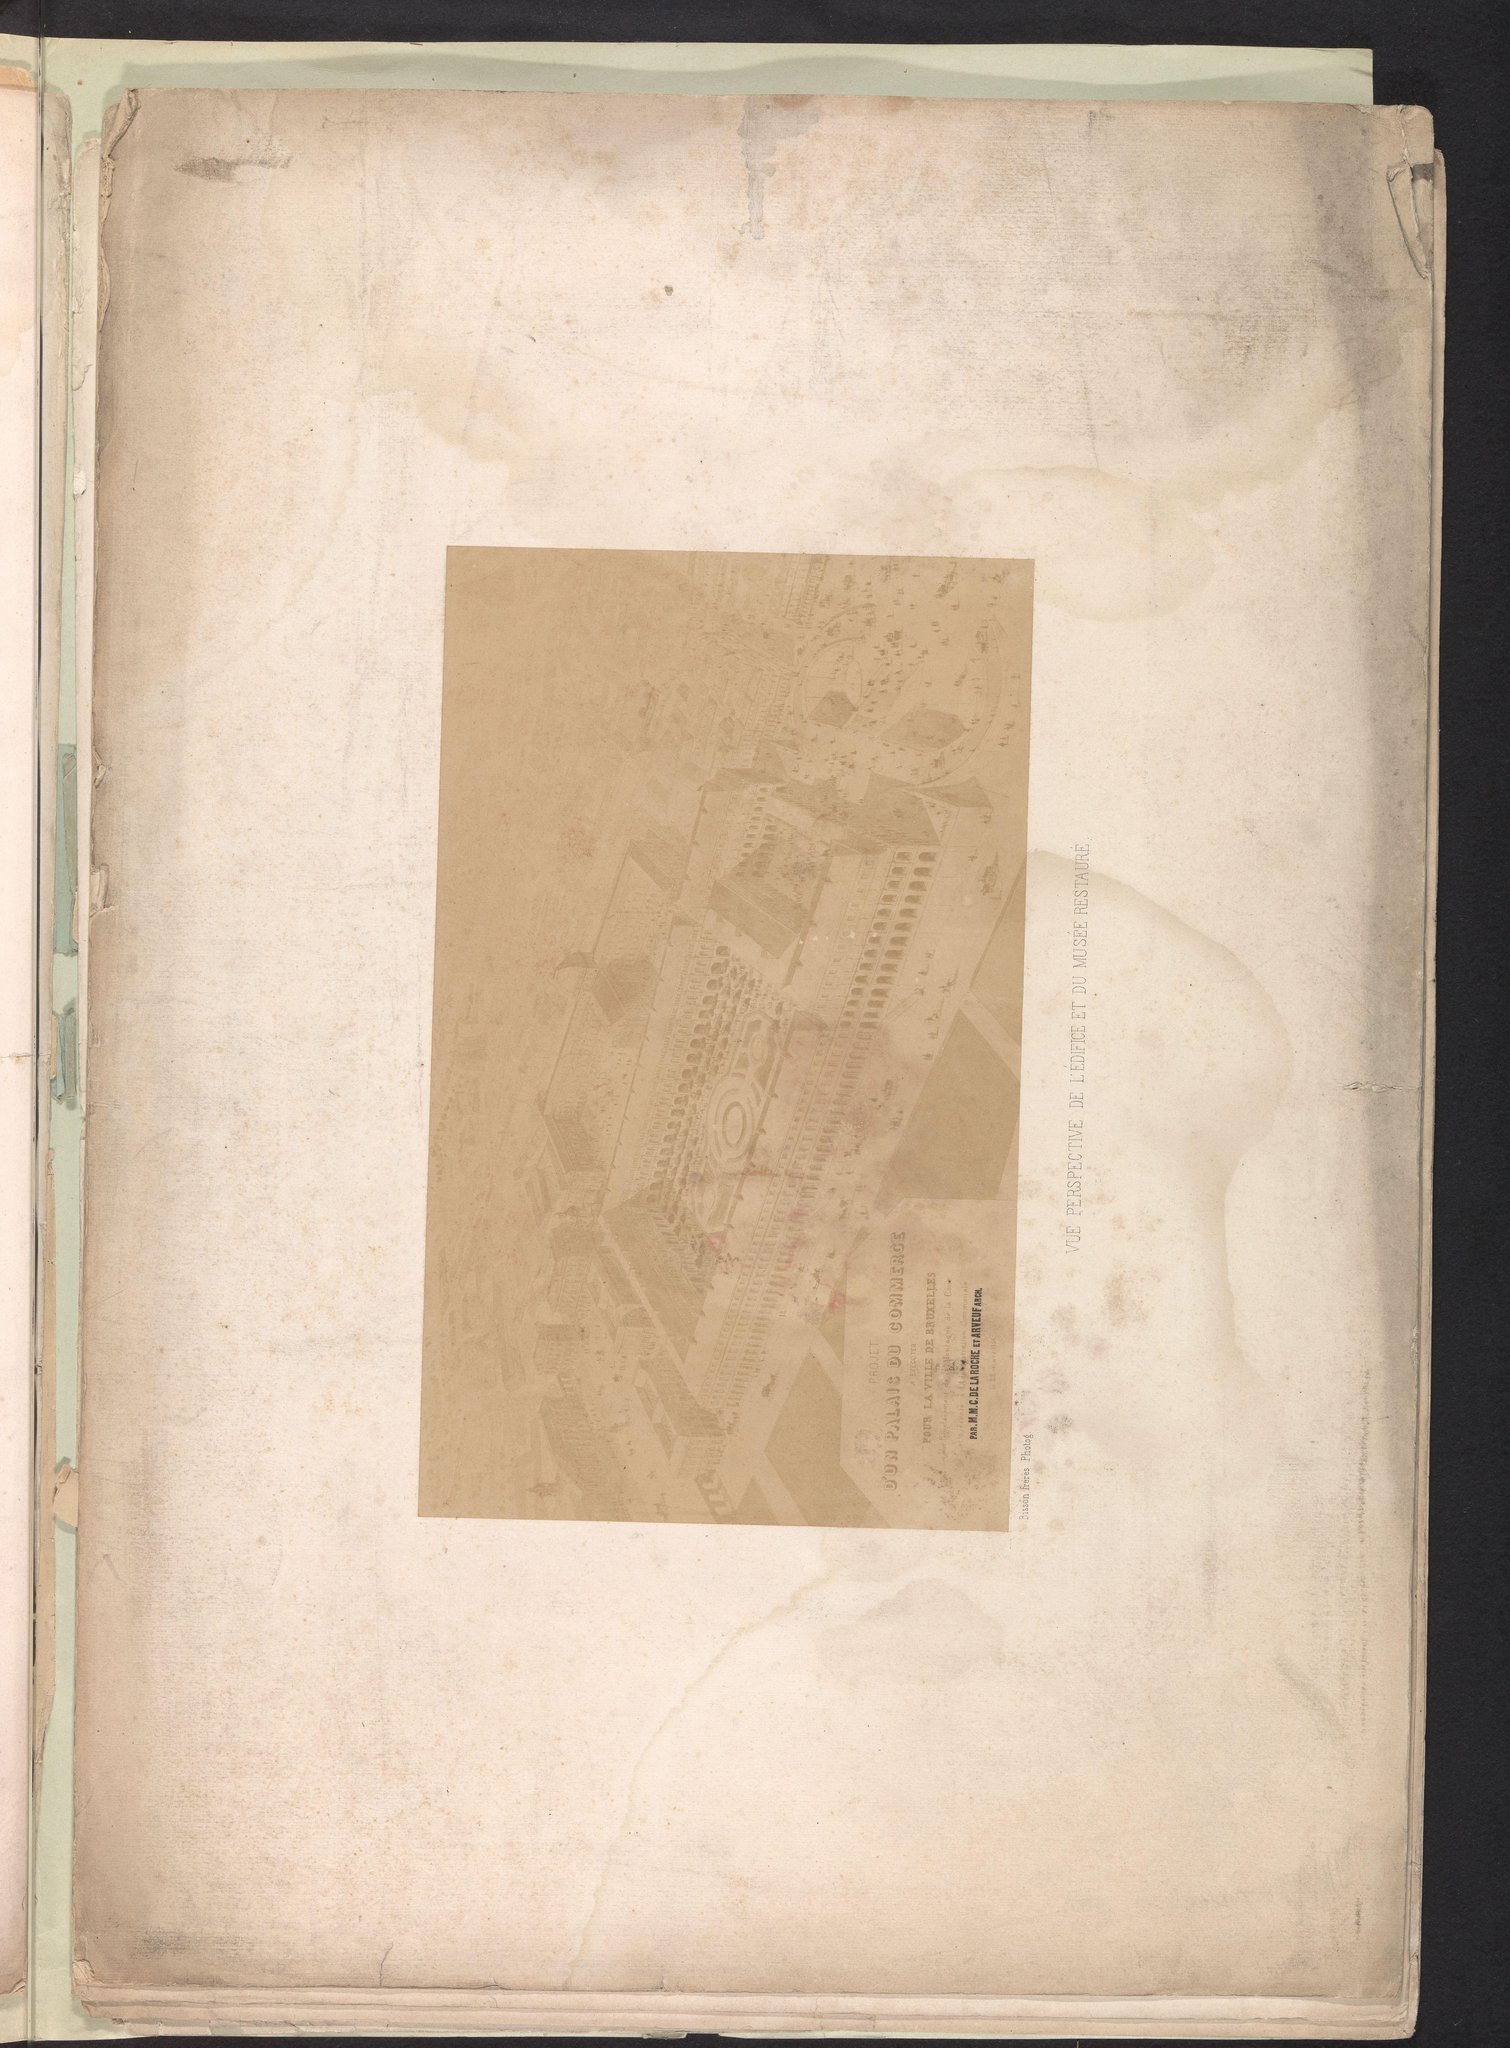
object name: page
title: Fotoreproductie van een tekening, voorstellende een exterieur van een handelsgebouw te Brussel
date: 1853-1854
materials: photographic support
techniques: albumen print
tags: chamber of commerce, façade (of house or building)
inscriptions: inscription: ‘par M.M.C. de La Roche et Arveuf arch.’